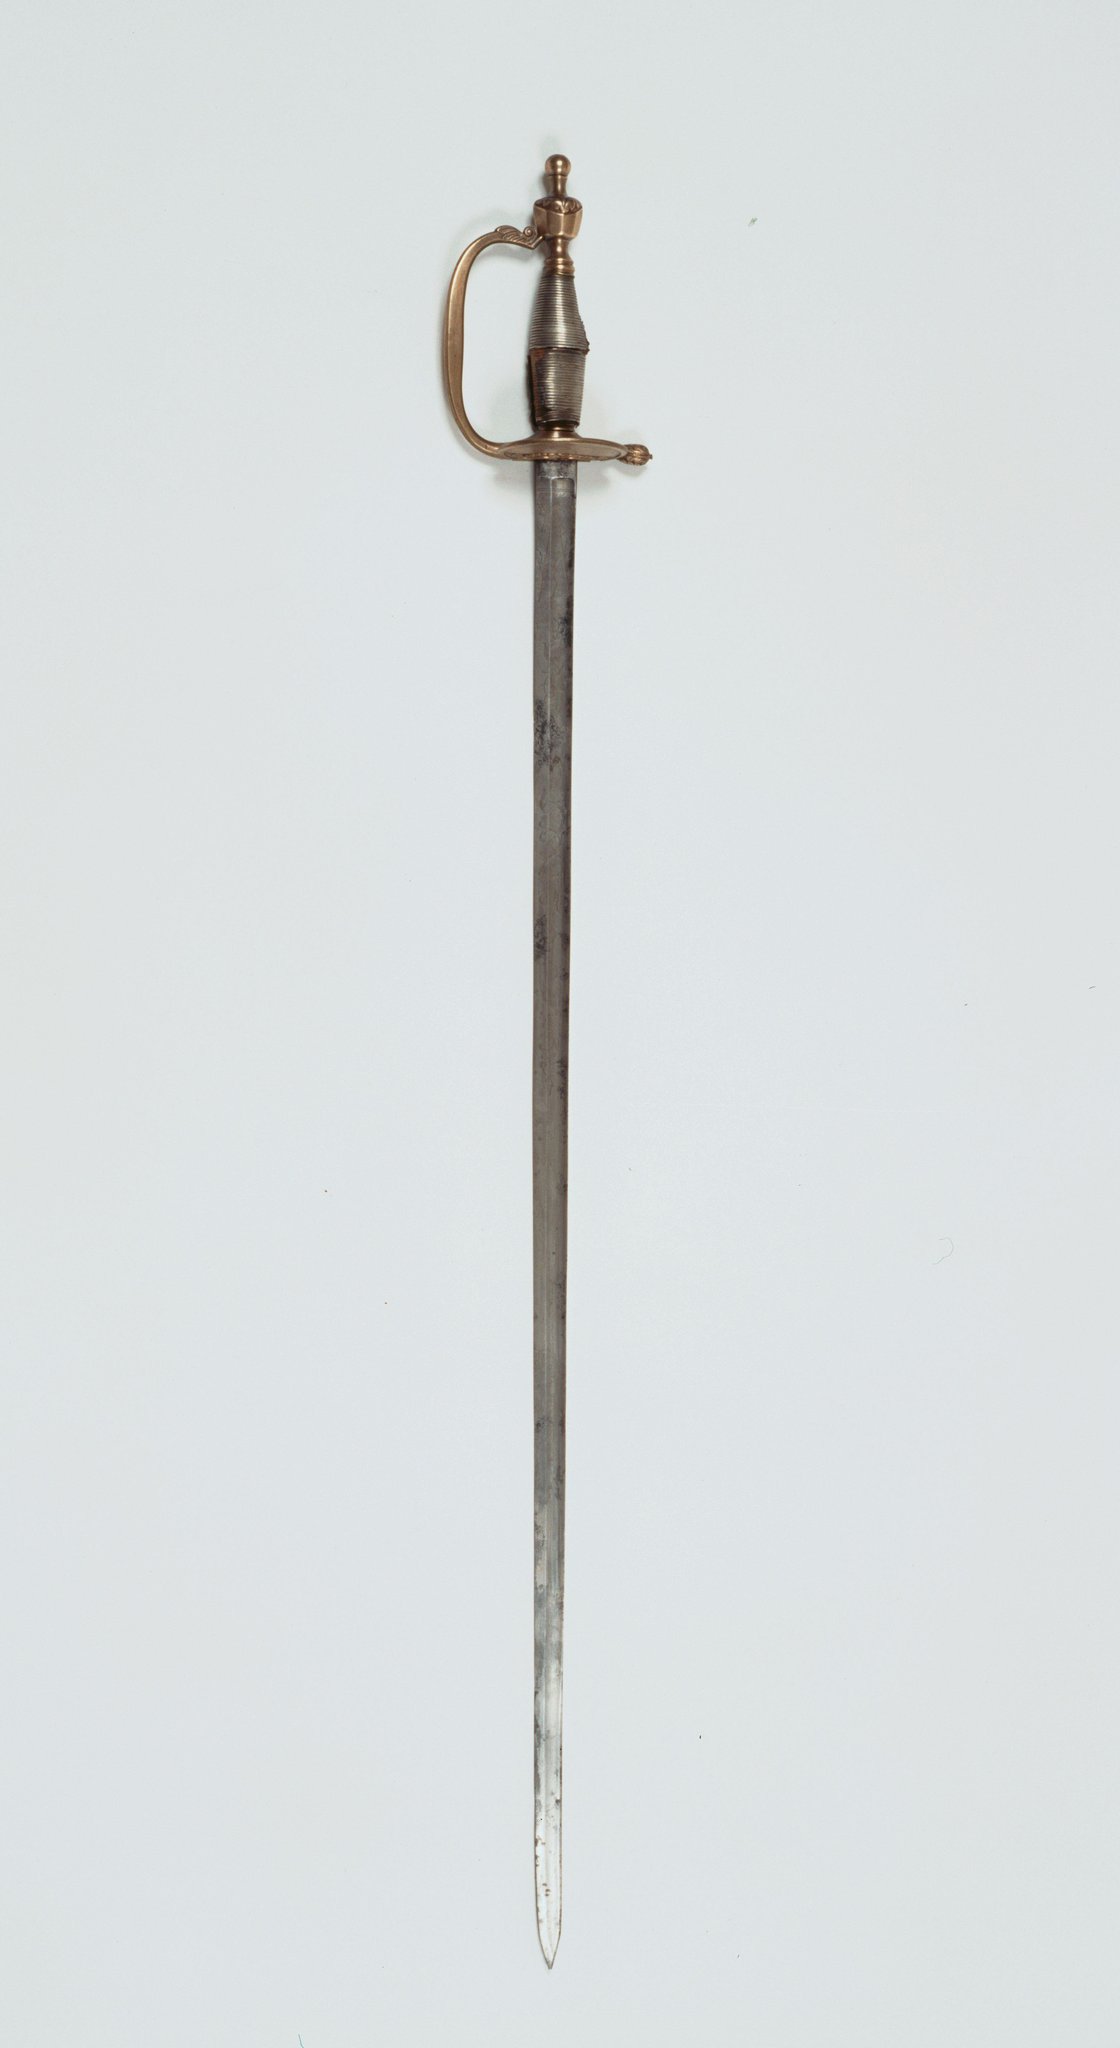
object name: sword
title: Degen met schede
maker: peter knecht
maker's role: weapon manufacturer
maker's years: 1798-1852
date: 1798-1852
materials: copper, iron, leather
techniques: engraving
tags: amsterdam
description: Nederlandse officiersdegen algemeen model M 1820